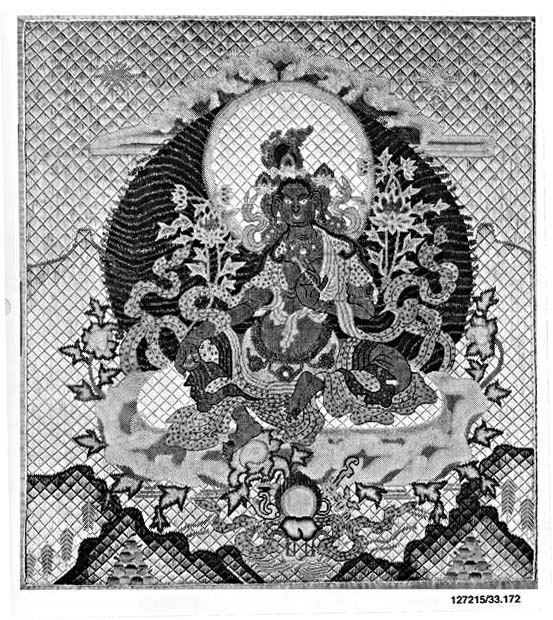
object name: hanging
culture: chinese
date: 1501-1600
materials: metal thread, silk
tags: goddess